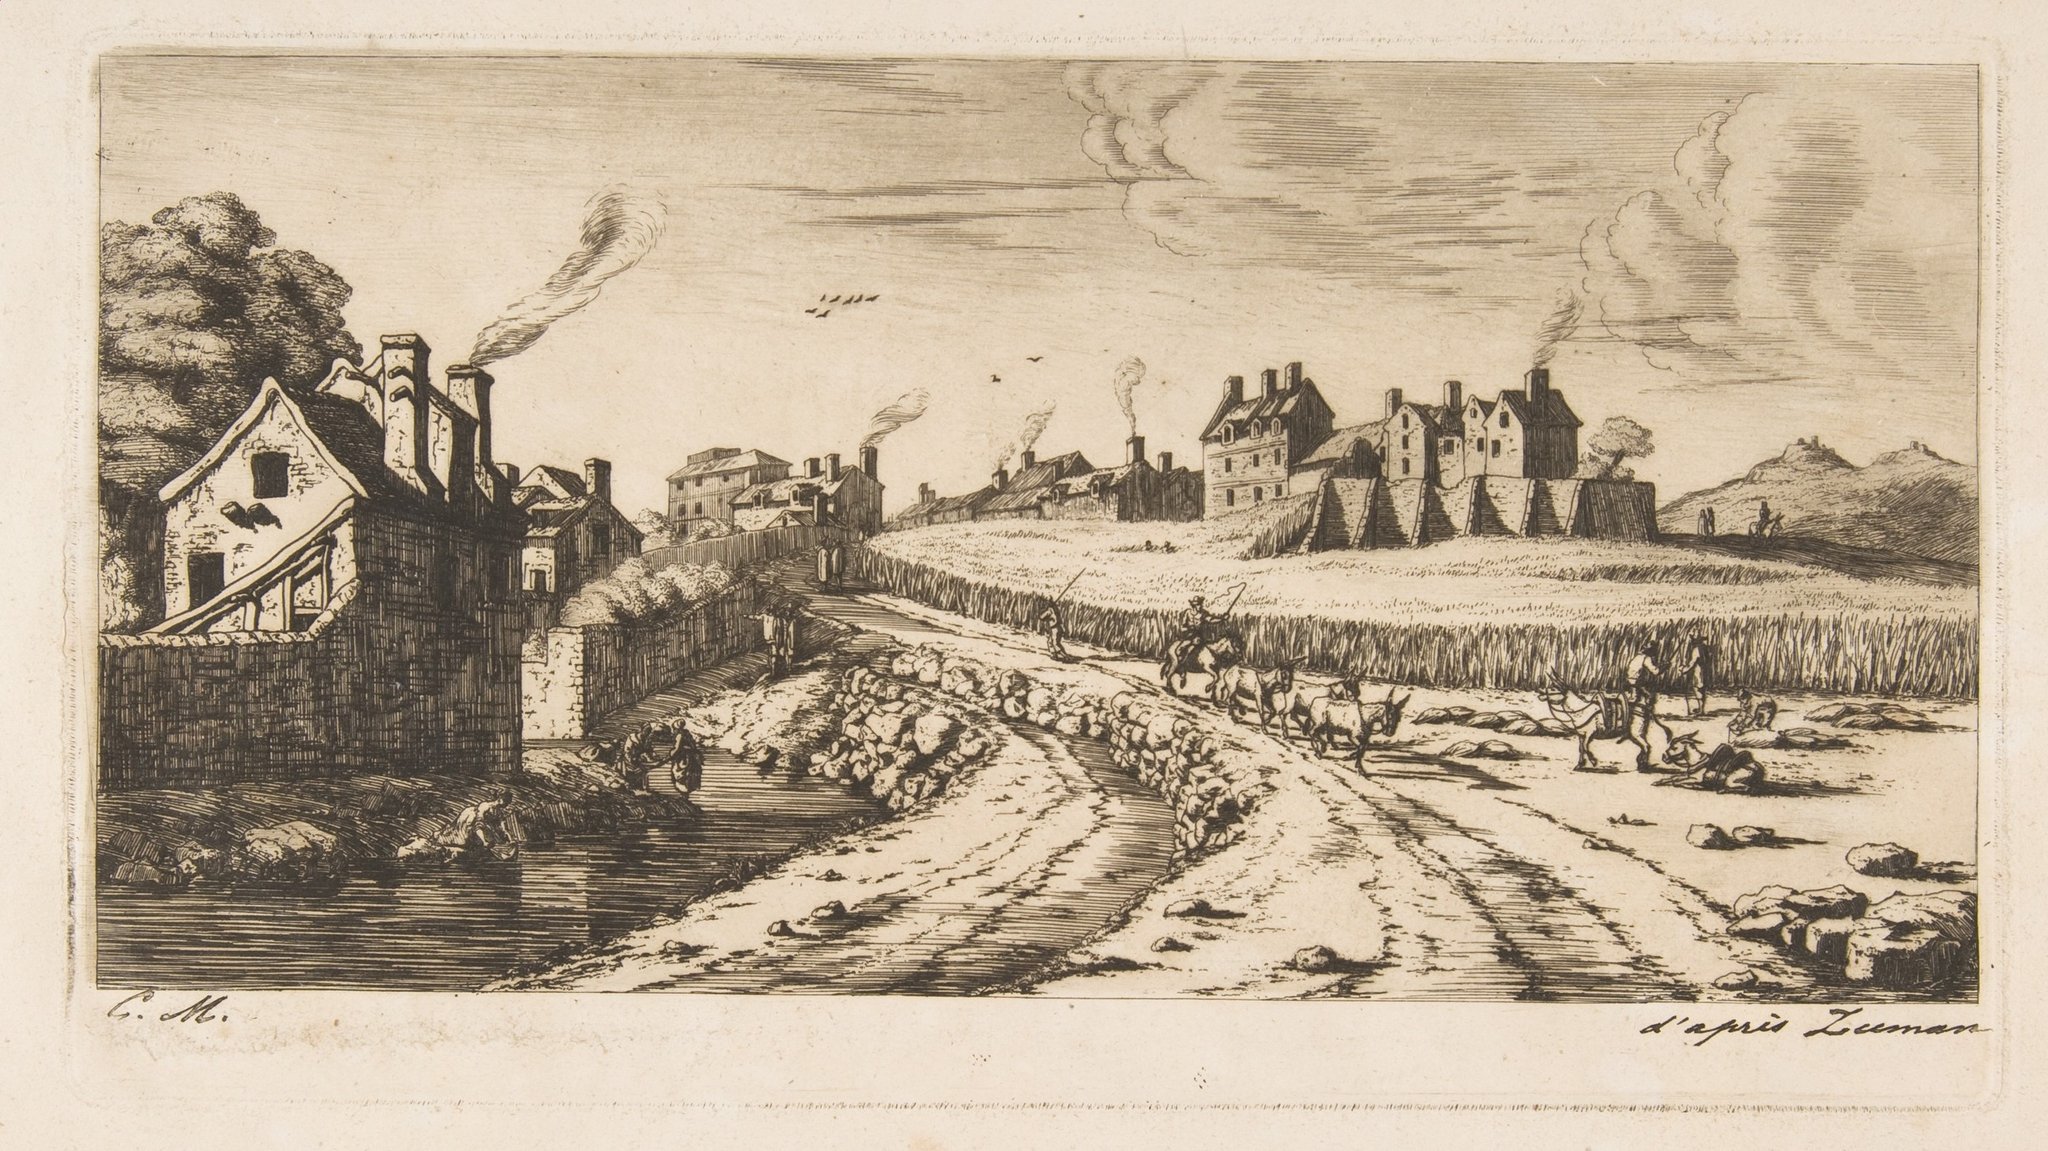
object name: print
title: Entrance to the Faubourg Saint-Marceau, Paris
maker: charles meryon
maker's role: artist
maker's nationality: french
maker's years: 1821-1868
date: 1850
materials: paper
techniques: etching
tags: buildings,roads,men,paris